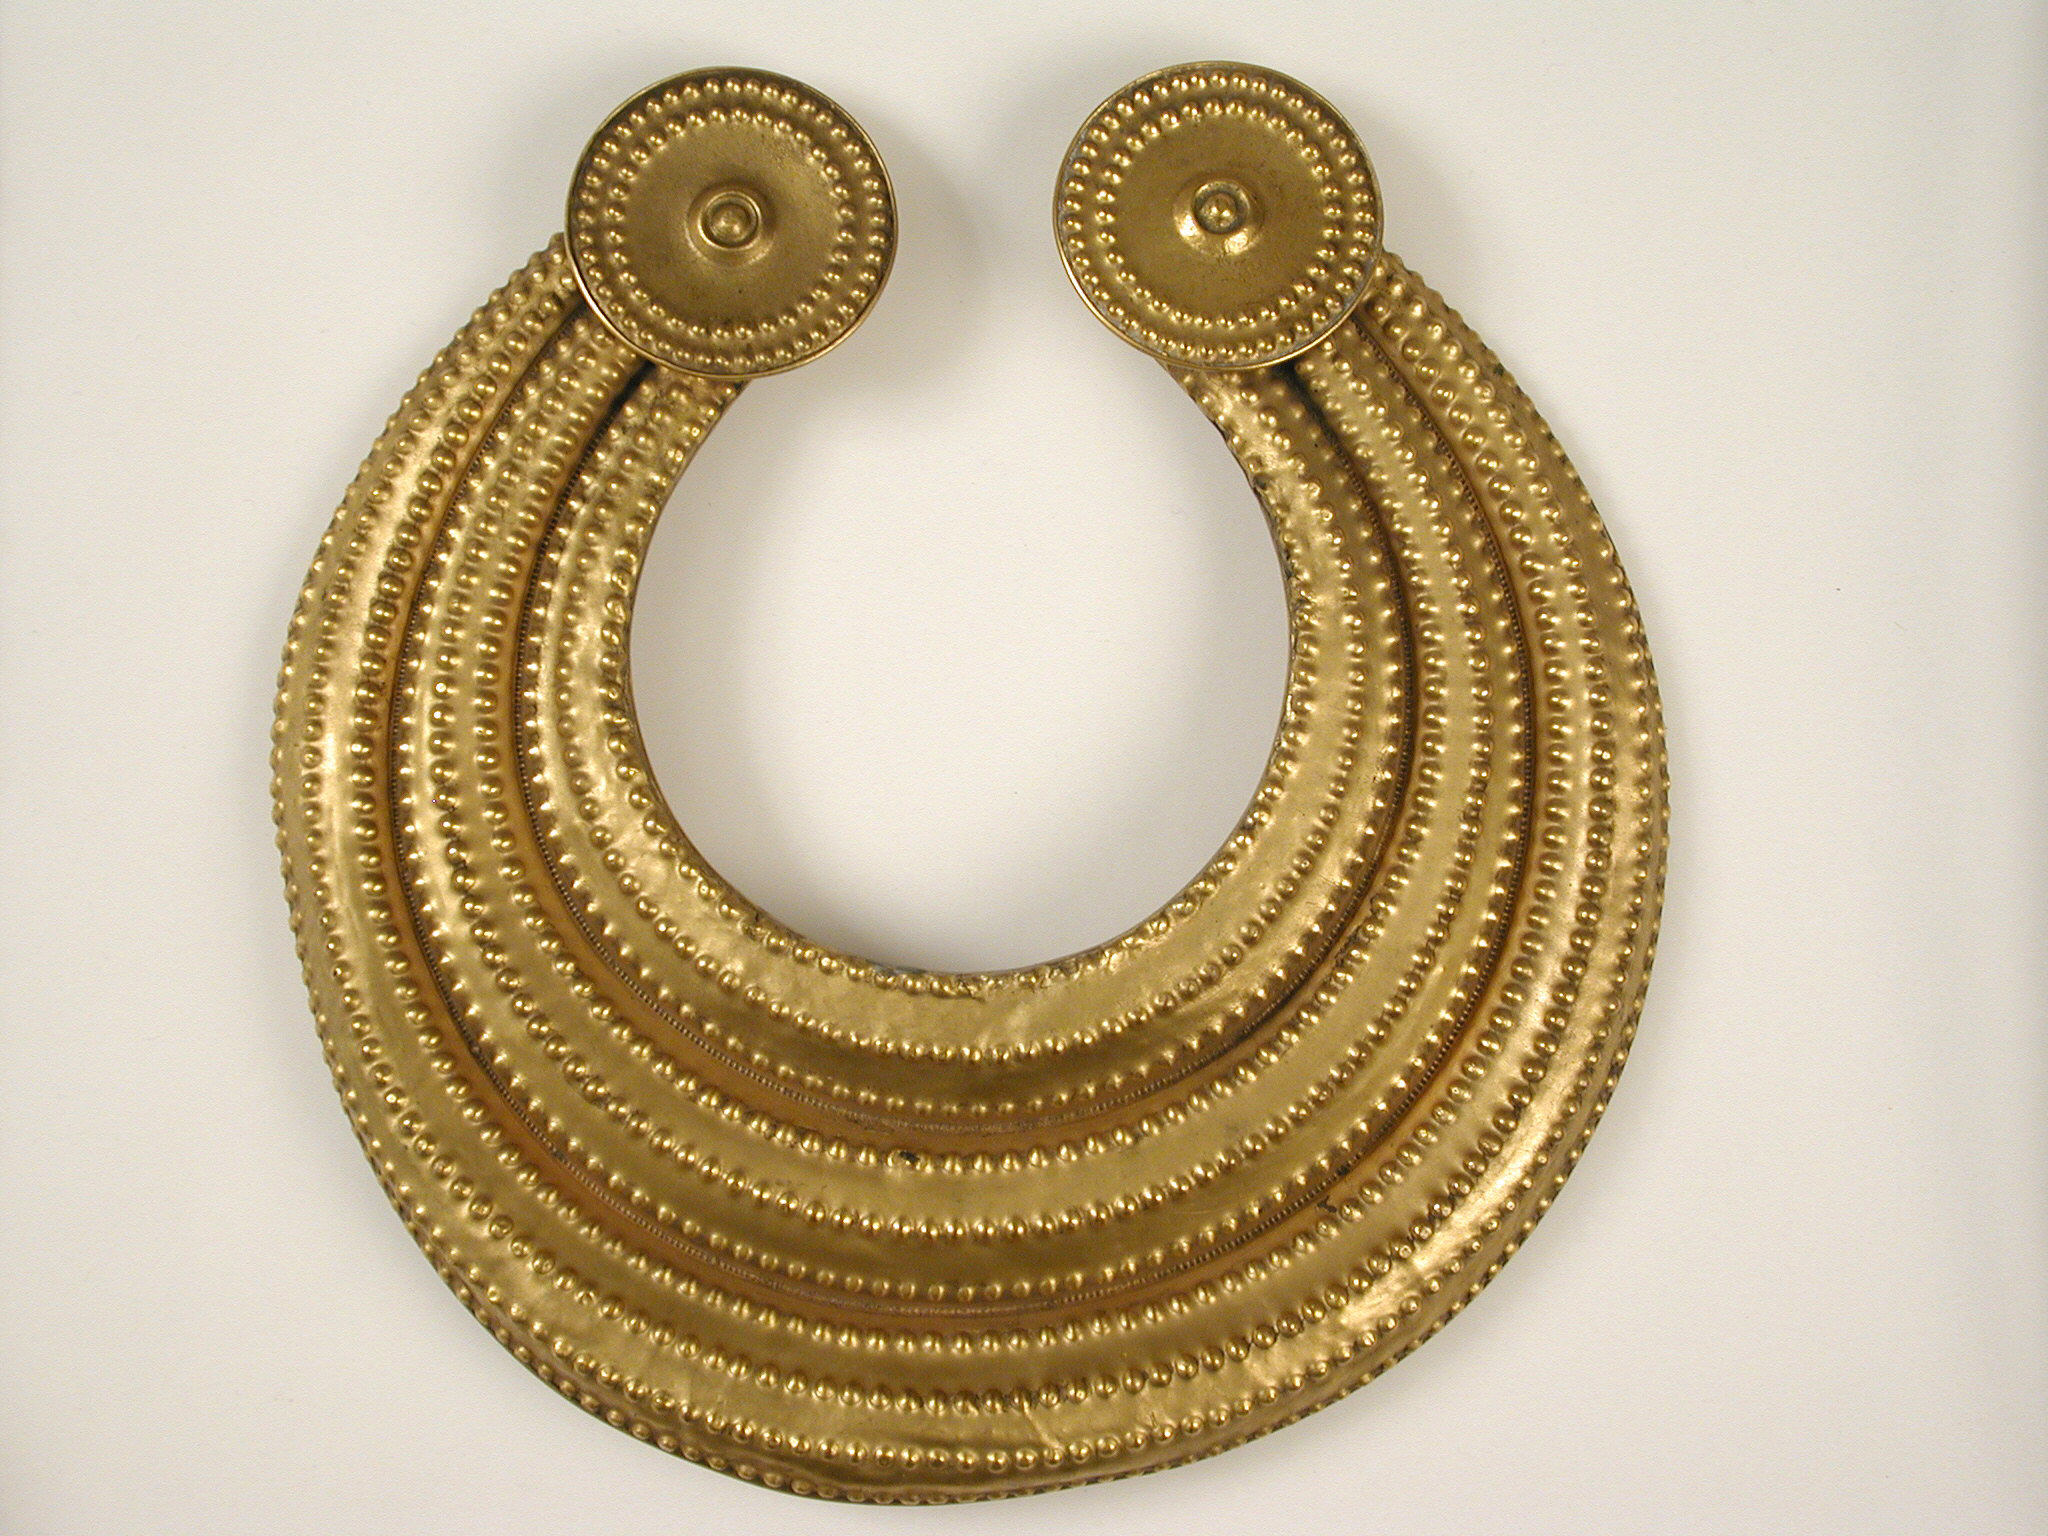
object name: crescent or gorget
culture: irish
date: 1901-1933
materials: gold